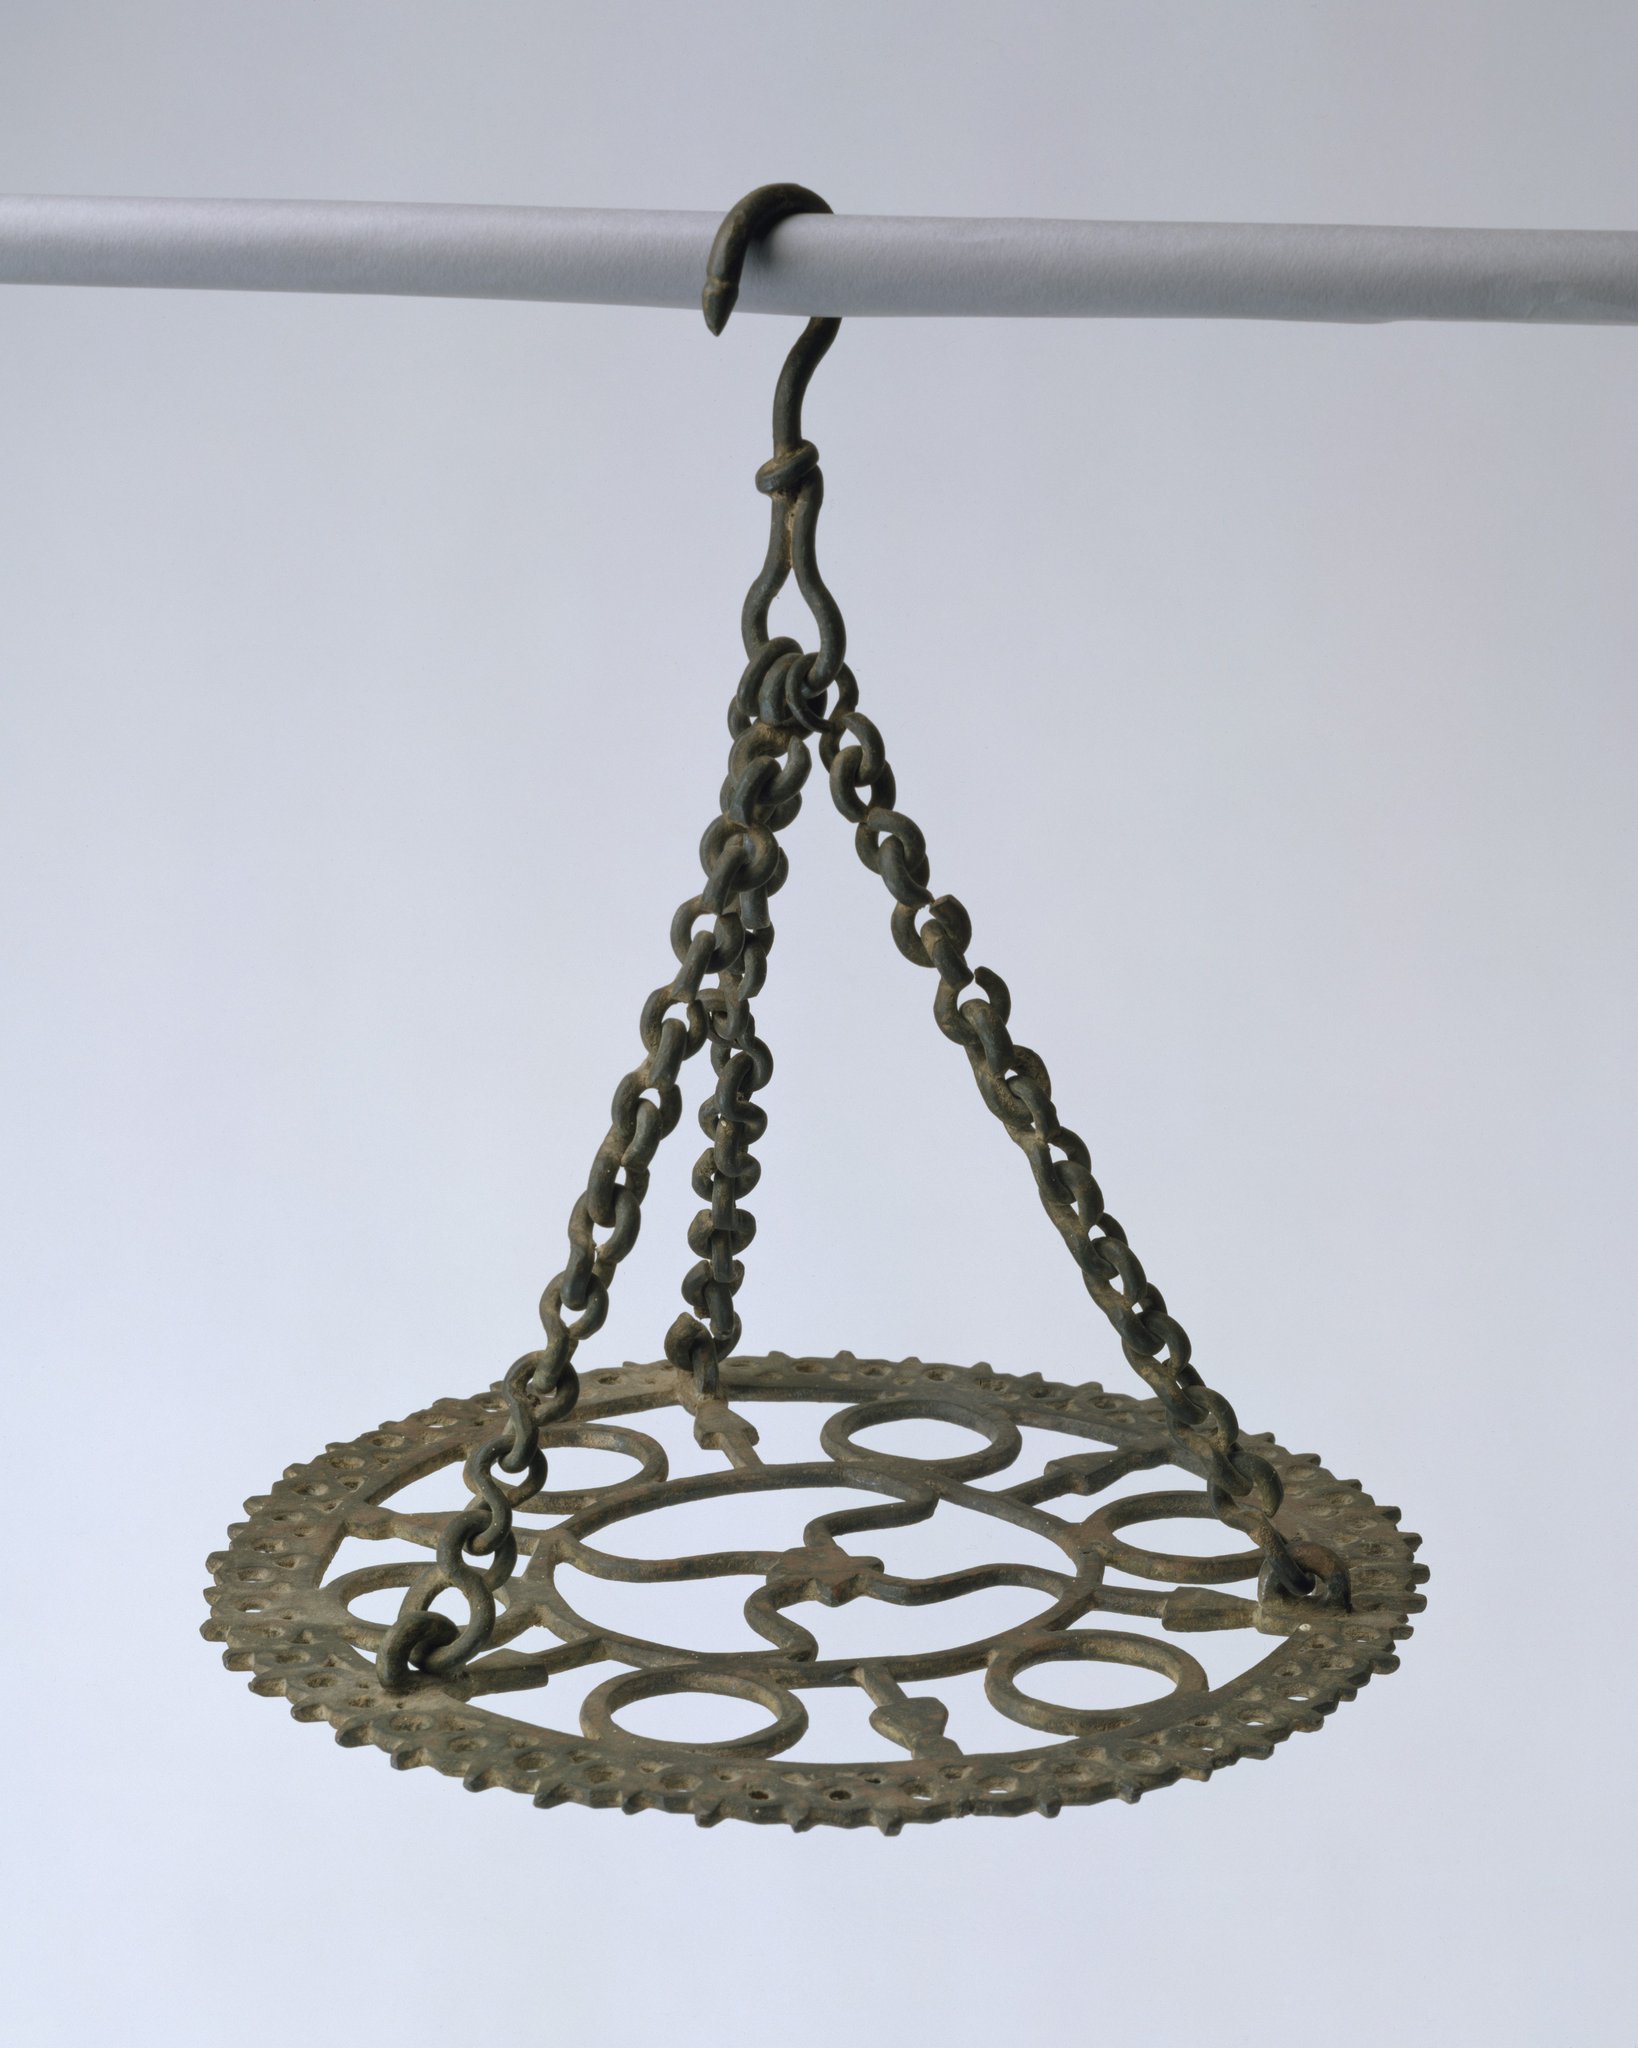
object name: polycandelon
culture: byzantine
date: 501-600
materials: copper alloy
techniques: casting